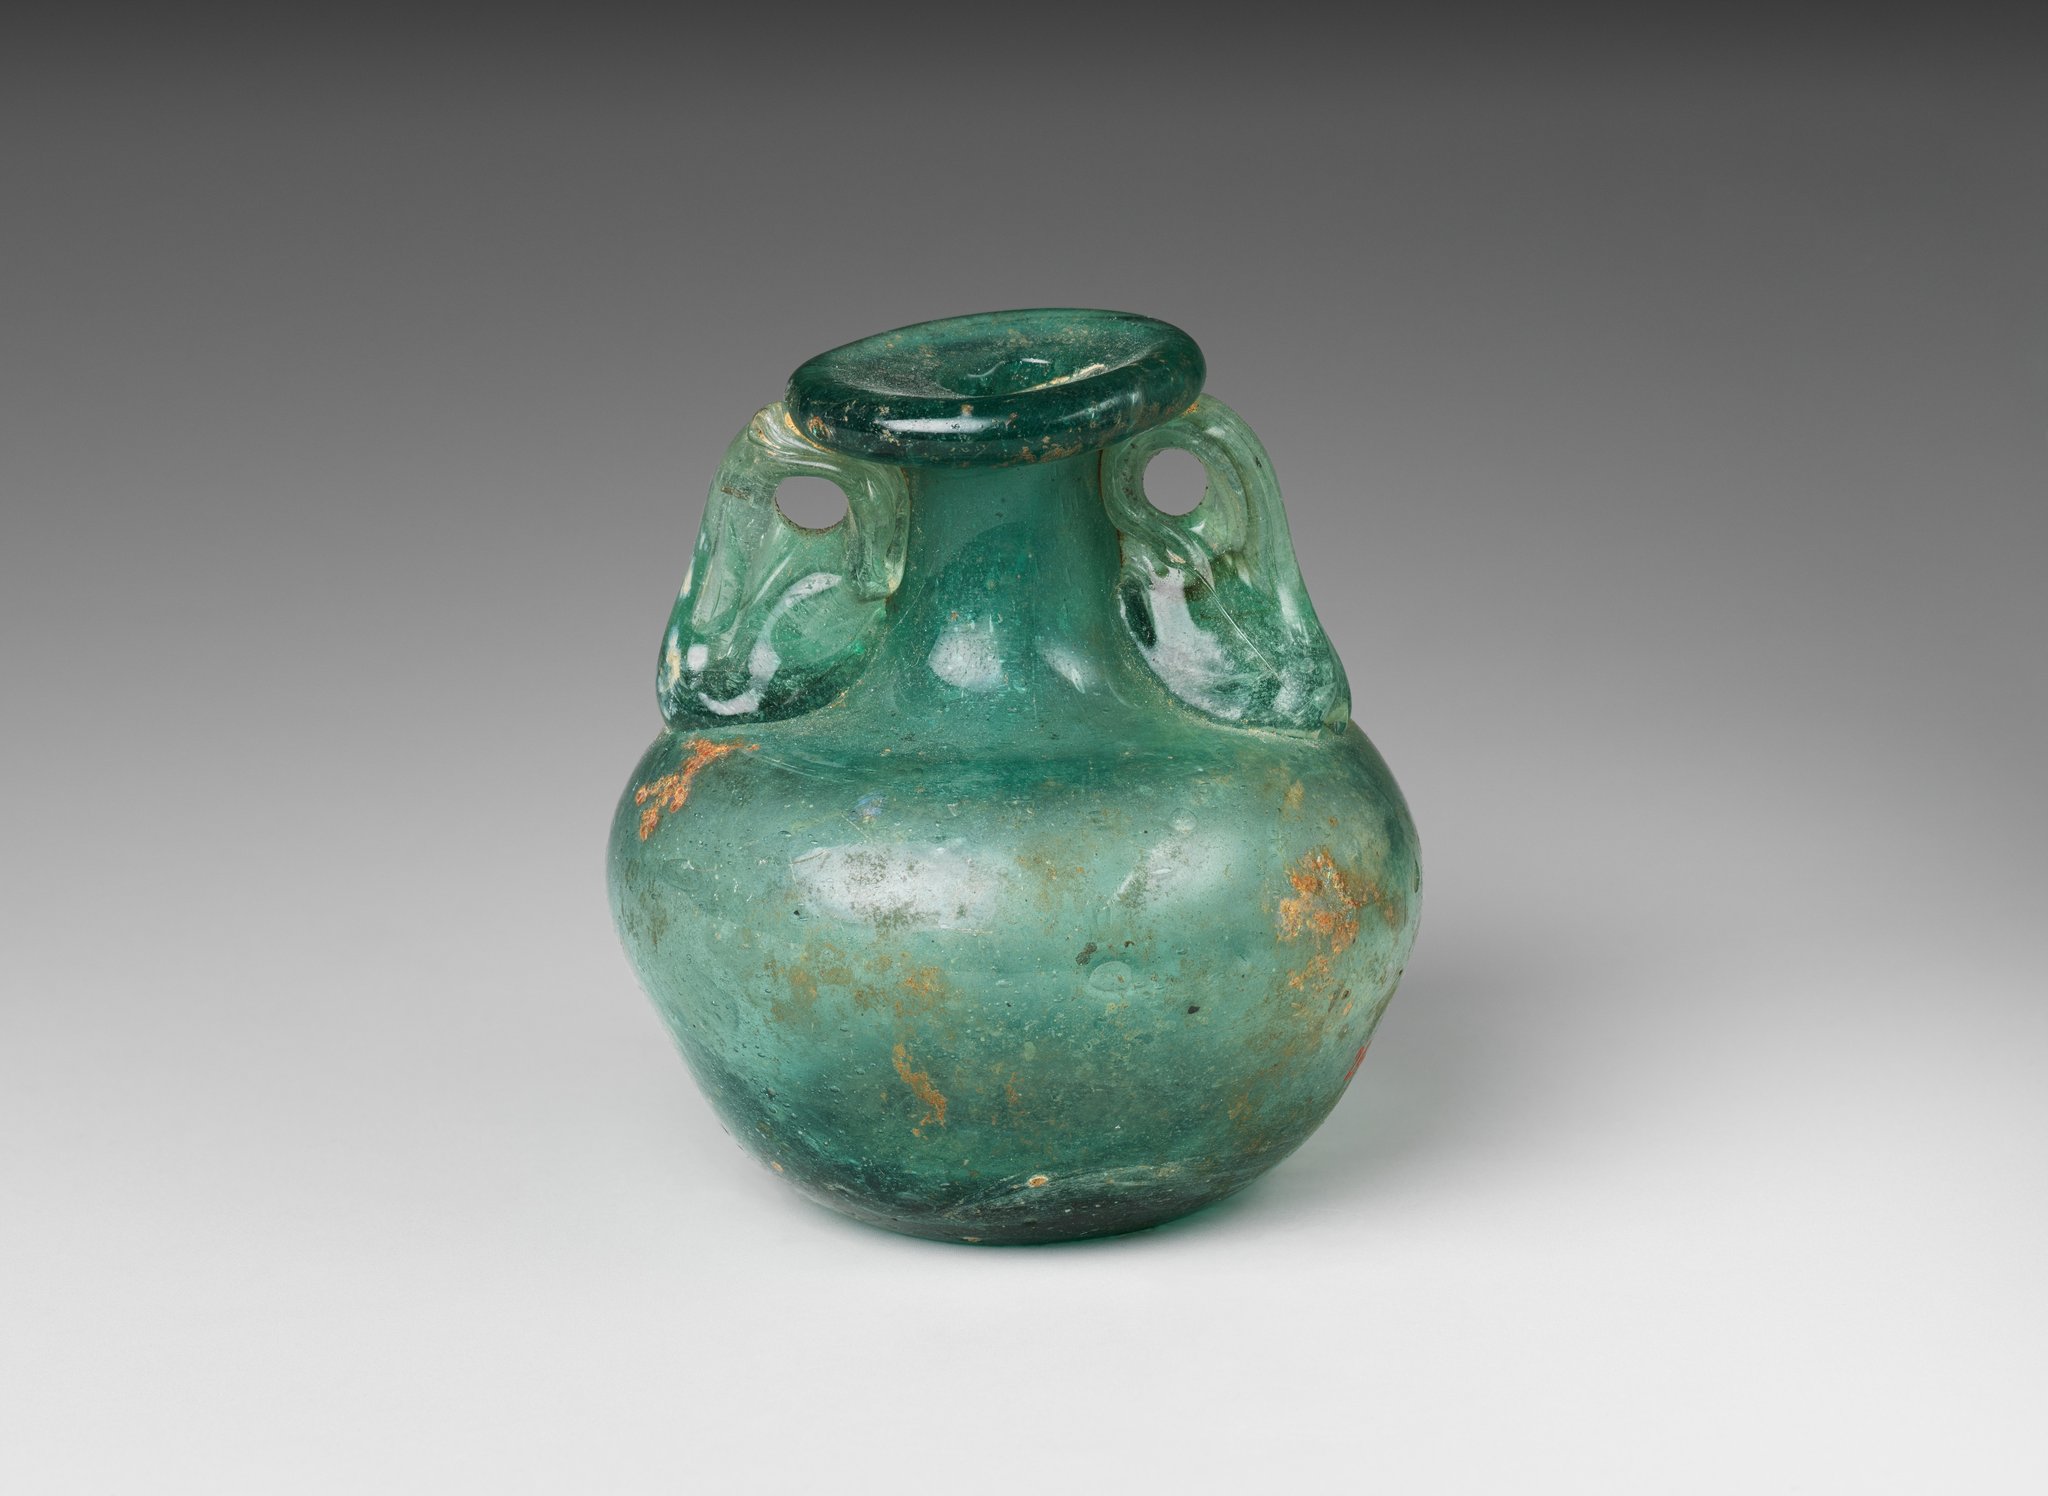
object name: vase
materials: glass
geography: egypt